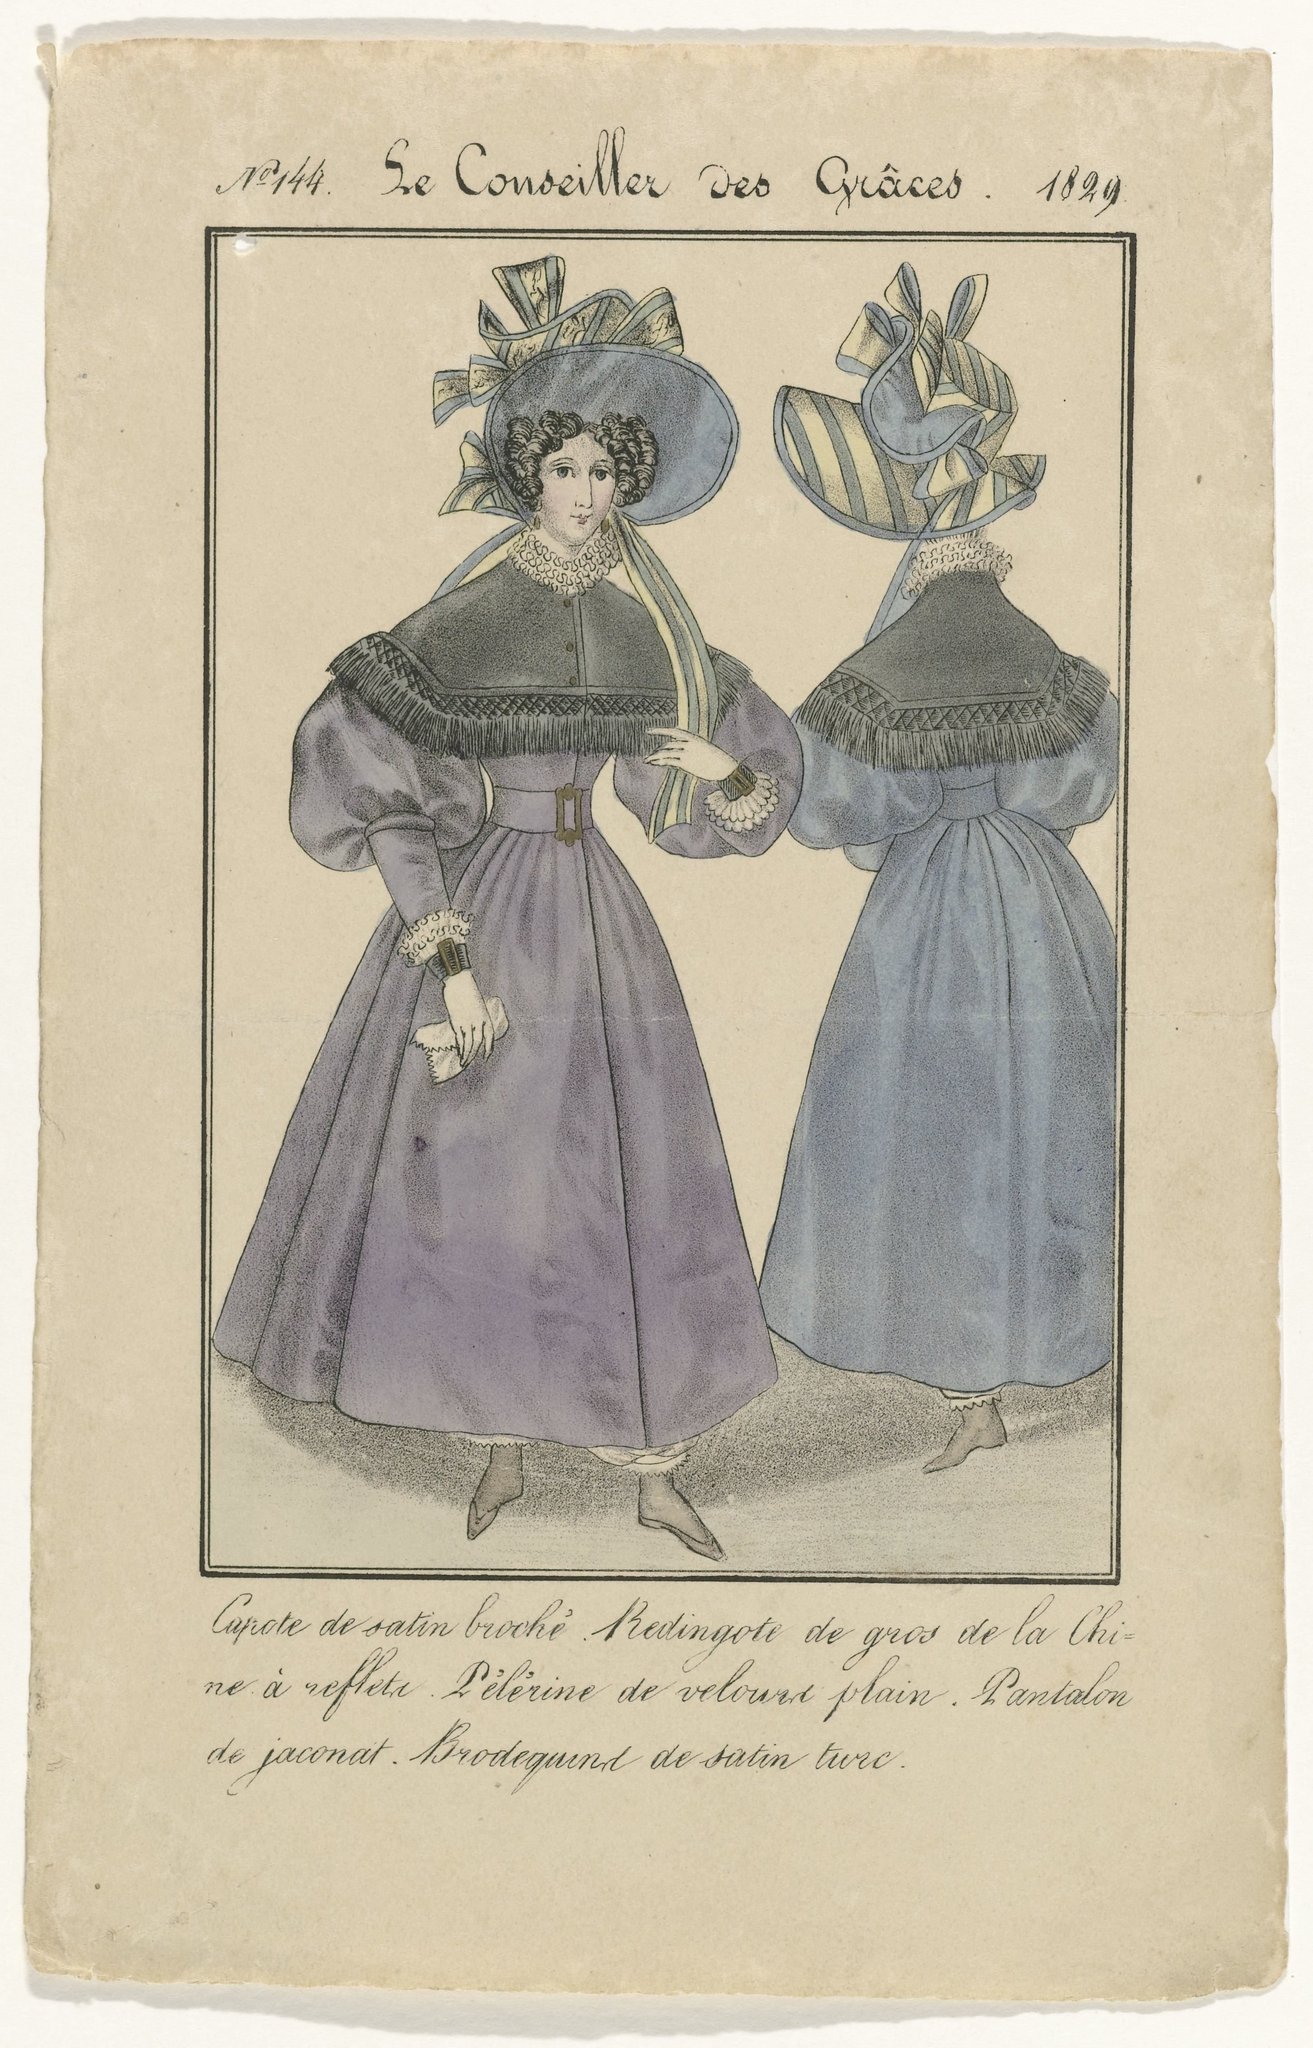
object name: fashion print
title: Le Conseiller des Grâces, 1829, No. 144: Capote de satin broché (...)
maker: Anonymous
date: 1829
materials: paper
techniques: hand coloring, lithograph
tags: head-gear (capote) (+ women's clothes), clothing for the upper part of the body (pelerine) (+ women's clothes), dress, gown: redingote (+ women's clothes), boots (+ women's clothes), trousers, breeches (+ women's clothes), fashion plates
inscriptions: caption: ‘Capote de satin broché. Redingote de gros de la Chine à reflet. Pélérine de velours plain. Pantalon de jaconat. Brodequins de satin turc.’, title: ‘Le Conseiller des Grâces’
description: Capote van gebrocheerd satijn. Redingote van ´gros de la Chine à reflet´. Pelerine van 'velours plain'. Lange broek van jaconat. Laarzen van 'satin turc'.